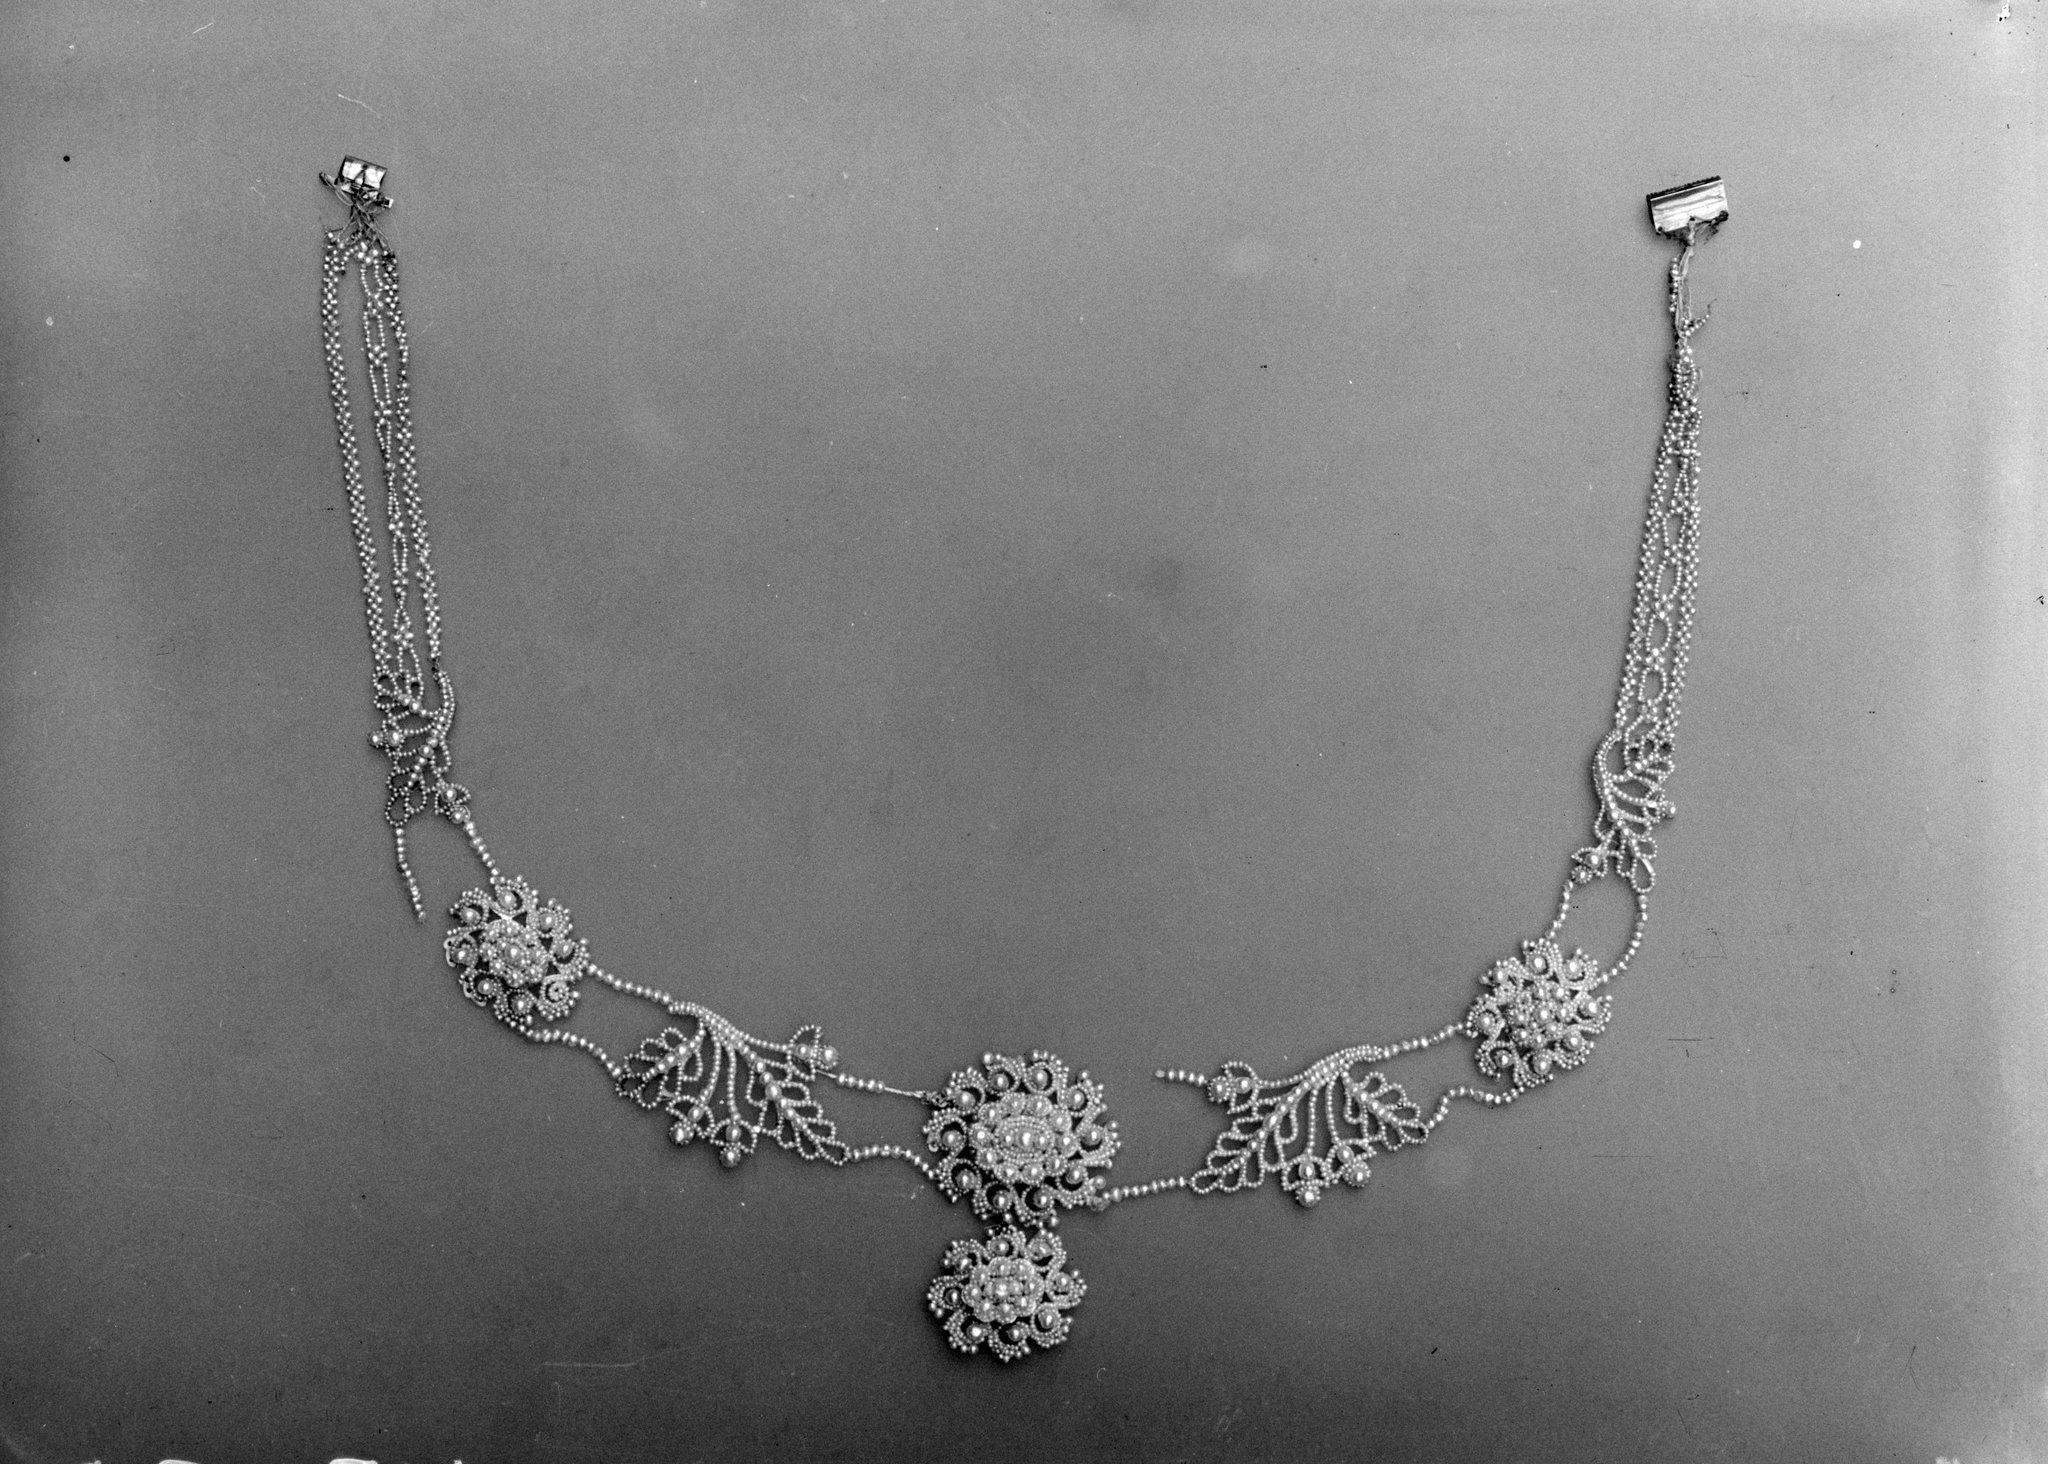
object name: necklace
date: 1800-1900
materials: pearl